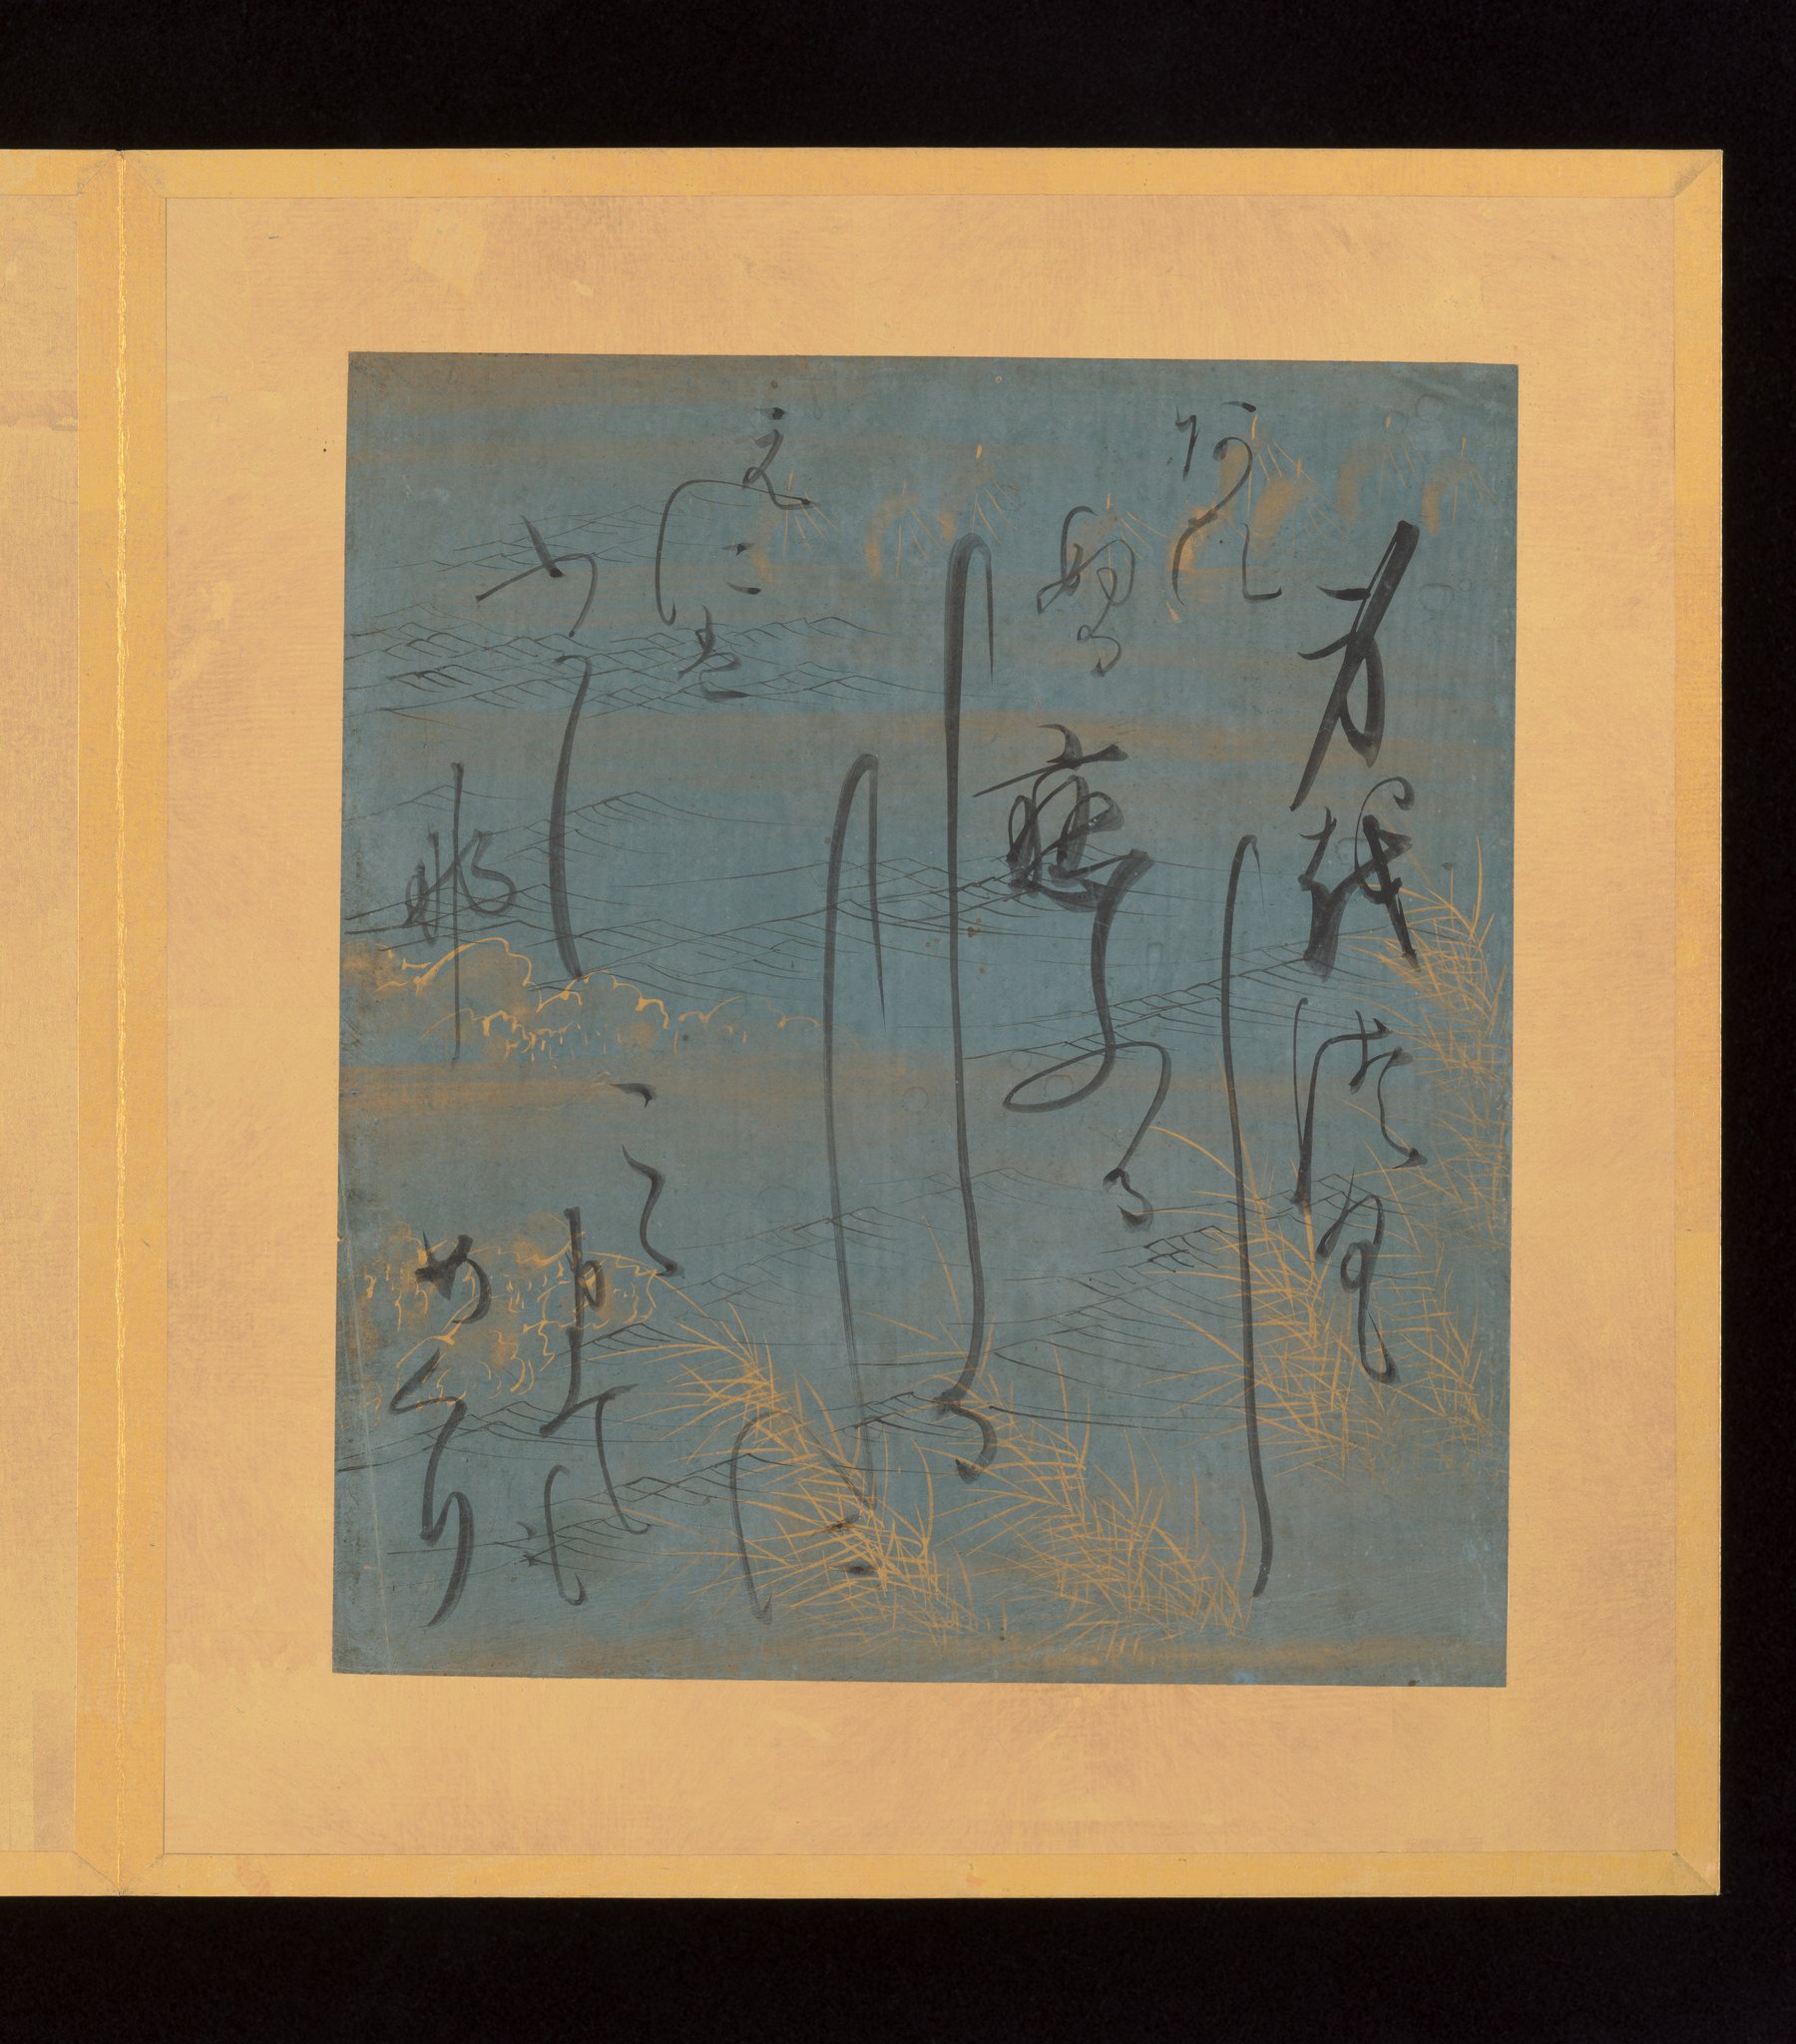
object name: album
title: Scenes and Calligraphic Excerpts from The Tale of Genji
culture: japanese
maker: tosa school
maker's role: artist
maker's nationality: japanese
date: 1601-1633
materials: gold, ink, paper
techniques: painting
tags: gardens,men,women